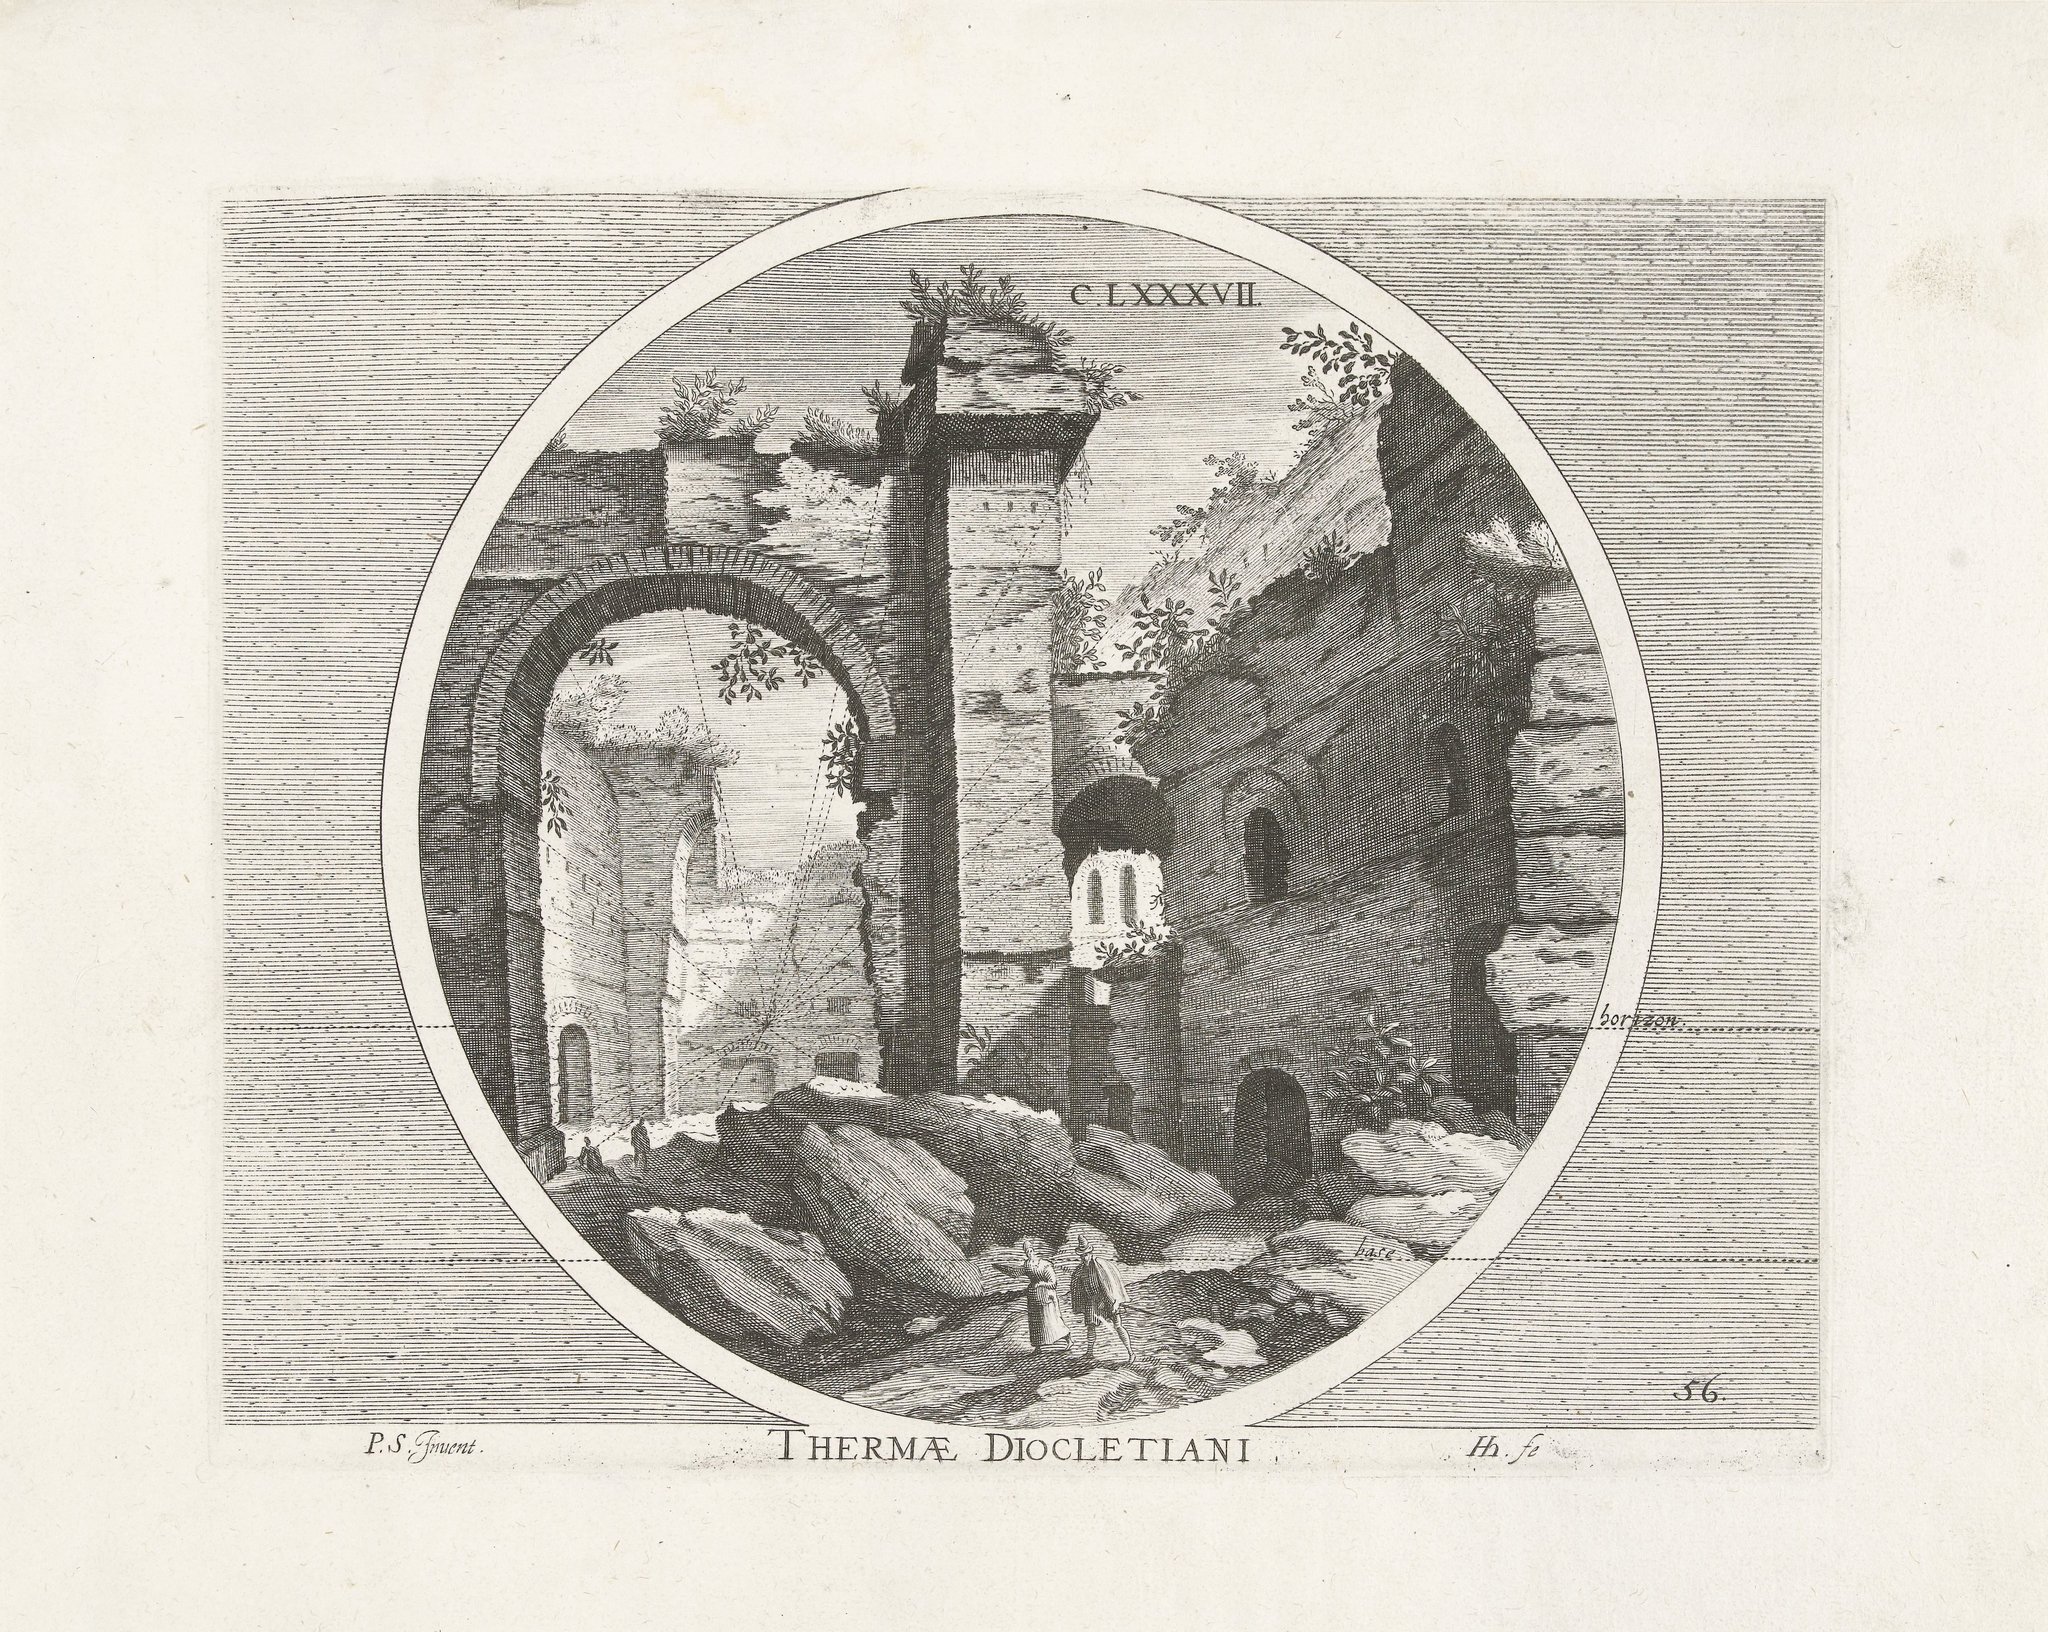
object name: print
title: Baden van Diocletianus, met arcade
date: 1600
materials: paper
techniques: engraving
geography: the hague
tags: ruin of a building ~ architecture, public baths, rome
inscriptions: collector's mark: Lugt 2228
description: Gezicht op de ruínes van de baden van Diocletianus, met op de voorgrond twee figuren. Perspectivische stippellijnen verbinden de gebouwen met de voorgrond en de horizon. Te lezen: horizon (rechtsmidden) en base (rechtsonder). In cirkel. Bovenaan: C.LXXXVII. Prent uit een serie van zes met voorstellingen van Romeinse ruïnes.